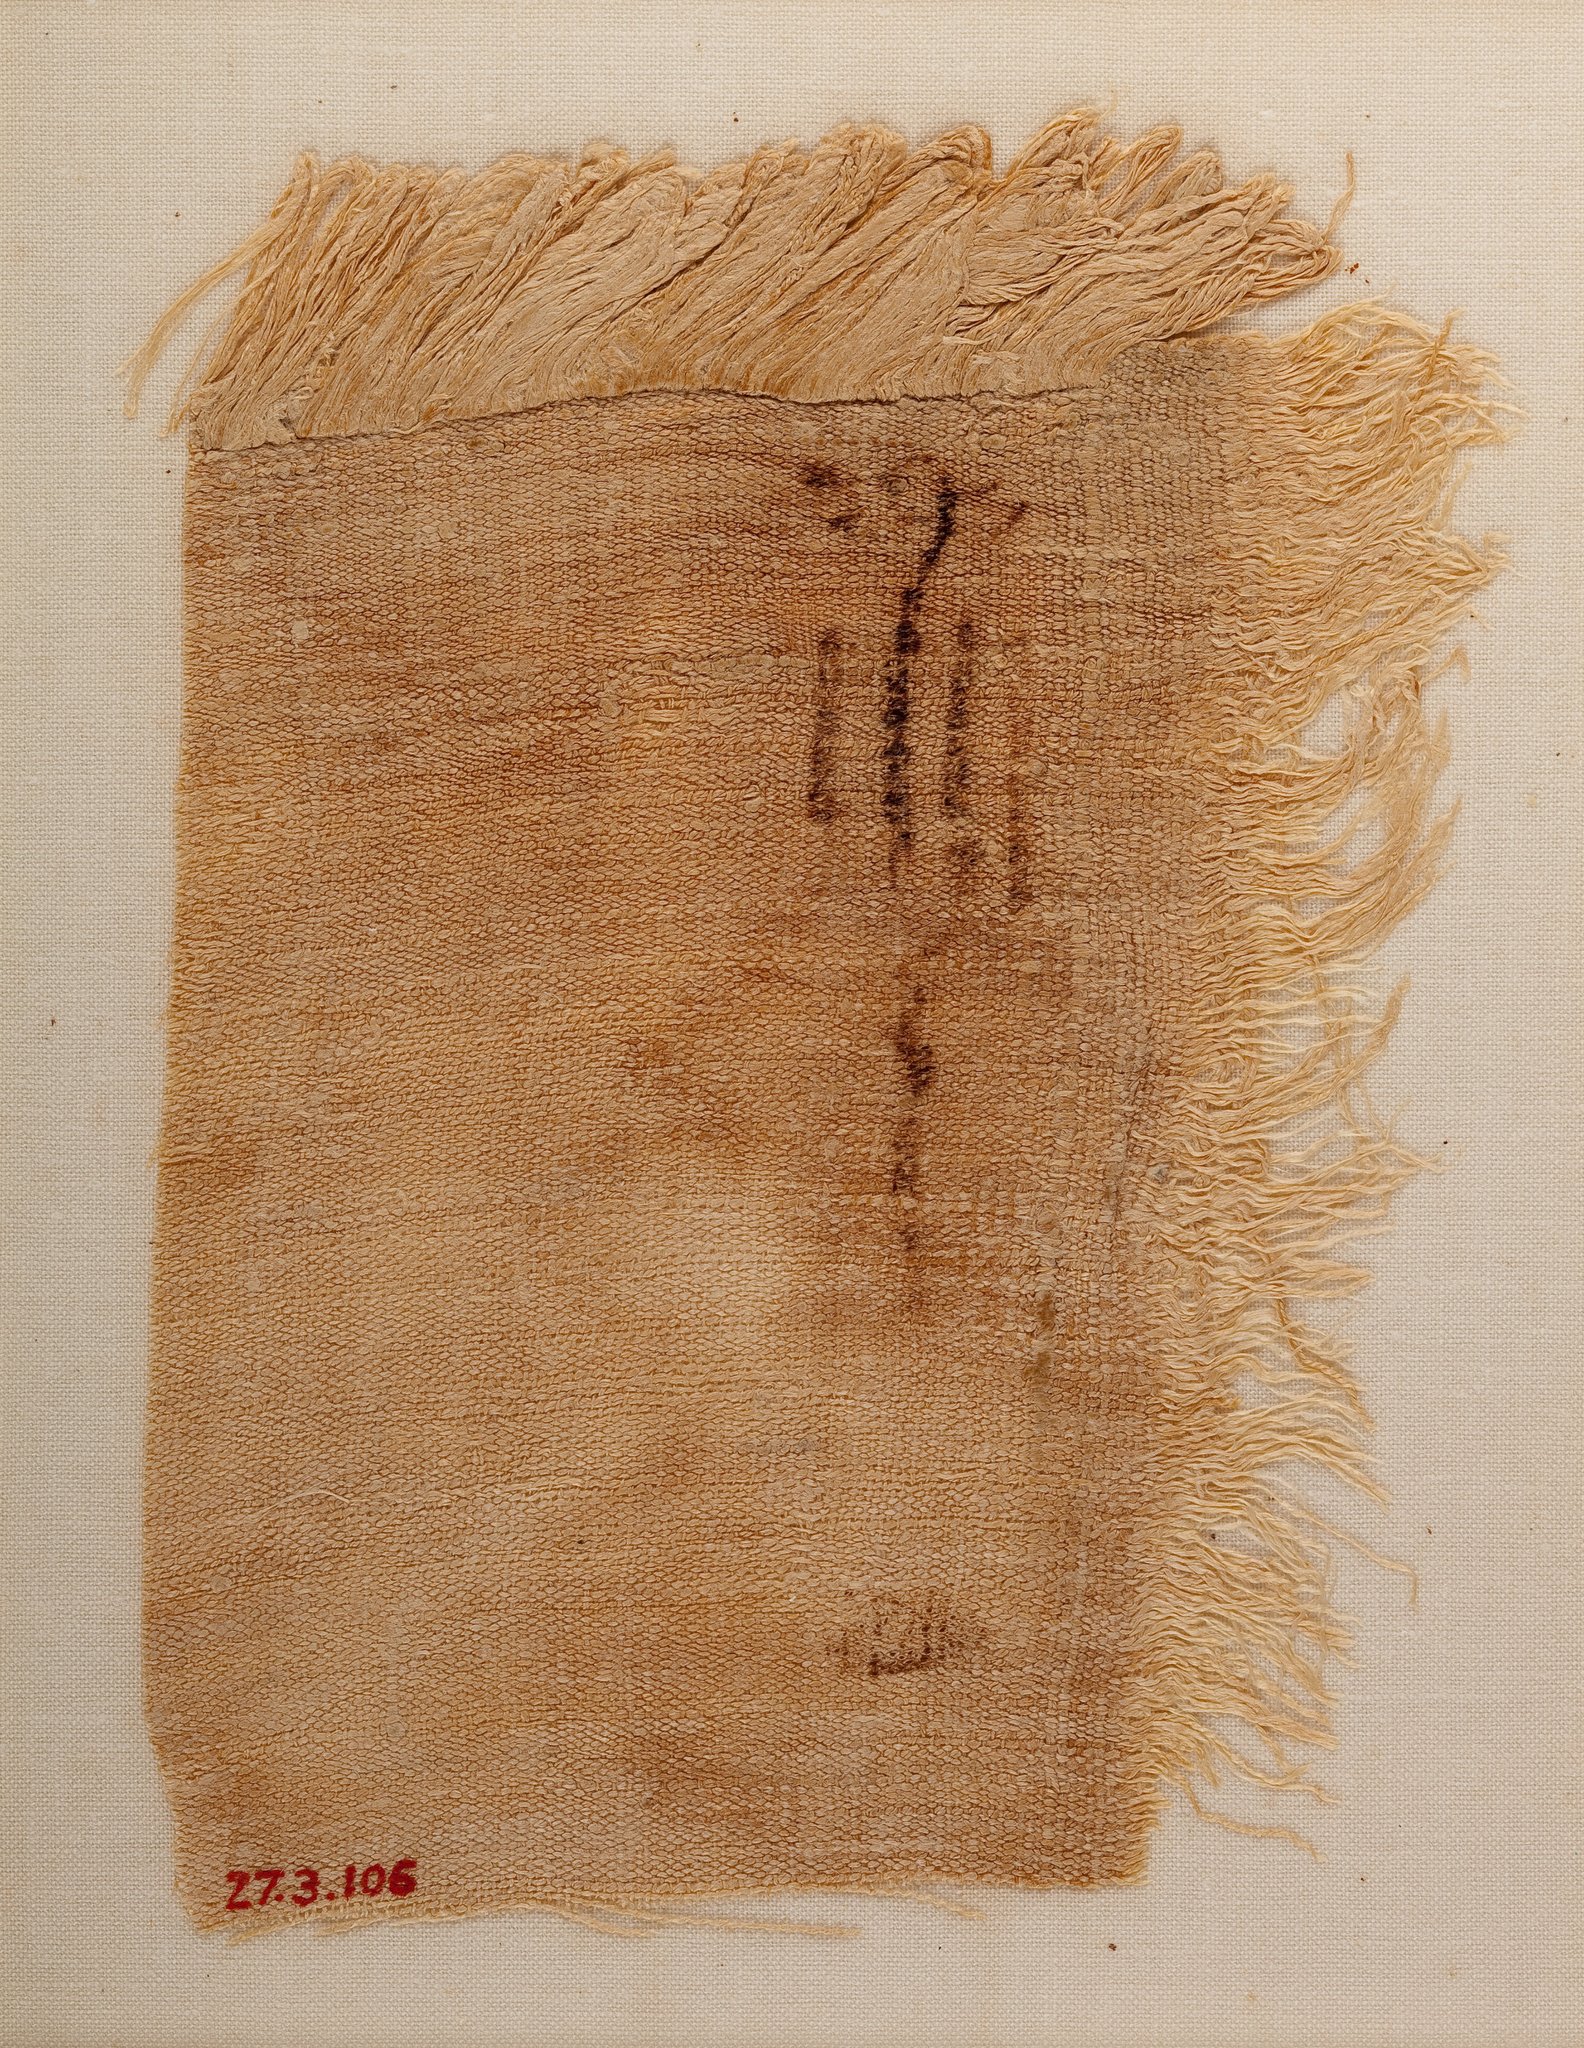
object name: linen mark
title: Linen mark (Type VII)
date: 1961-1917 BCE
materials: linen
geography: egypt